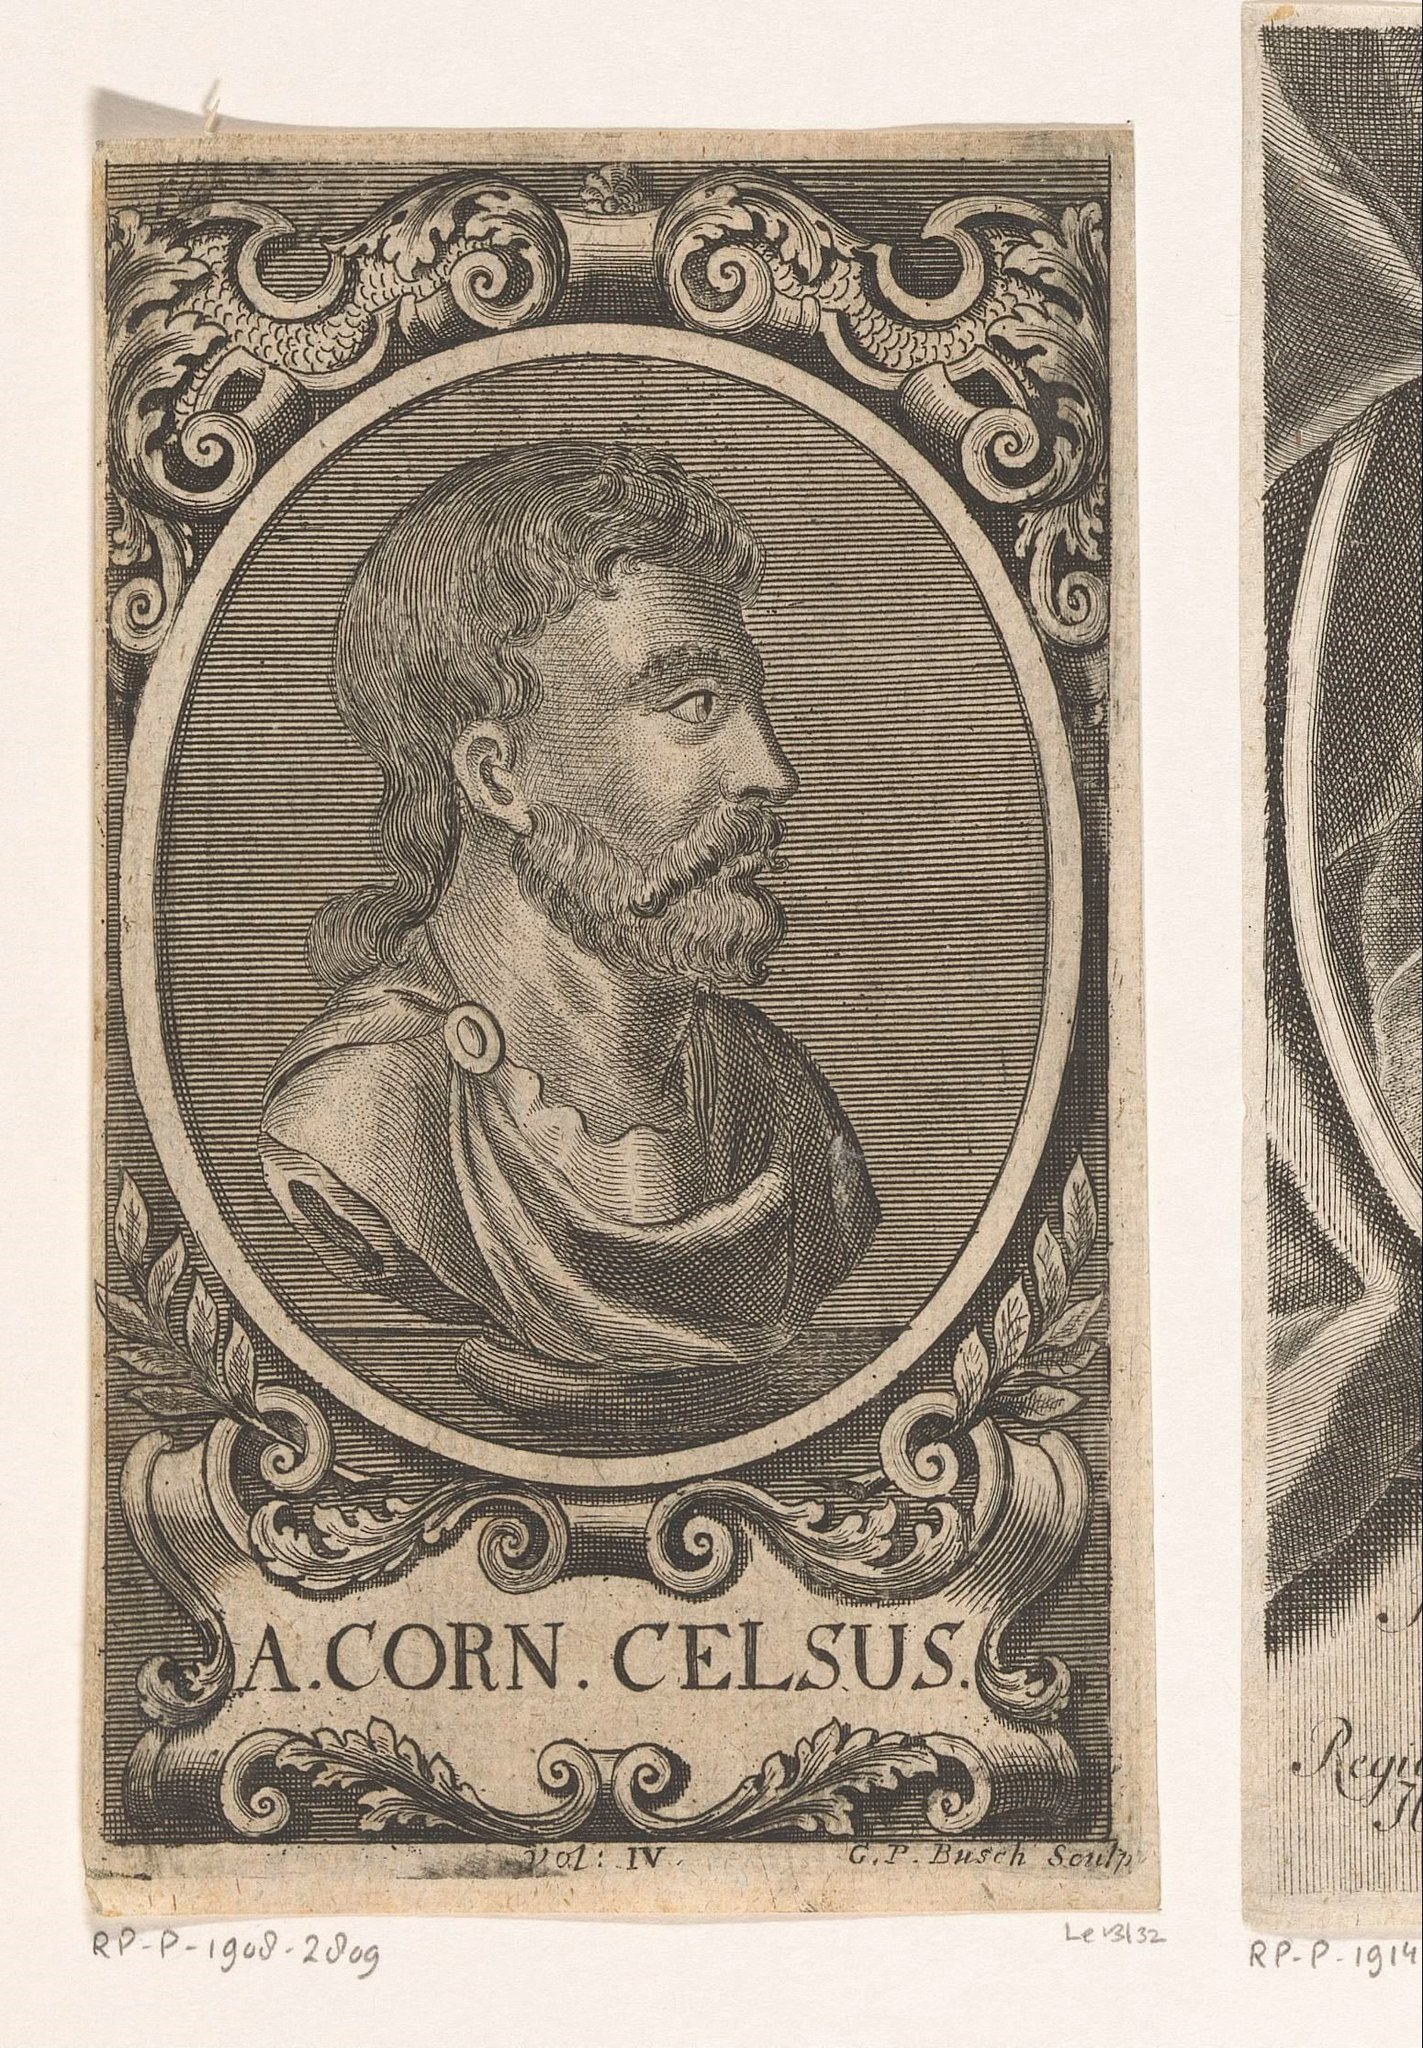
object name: book illustration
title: Portret van Aulus Cornelius Celsus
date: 1719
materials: paper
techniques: engraving, etching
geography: berlin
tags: historical persons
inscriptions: collector's mark: Lugt 2228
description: Prent afkomstig uit: Acta Medicorum Berolinensium, in Incrementum Artis & Scientiarum collecta & digesta. Volumen IV. Berlijn: Gottfried Gedicke, 1719.